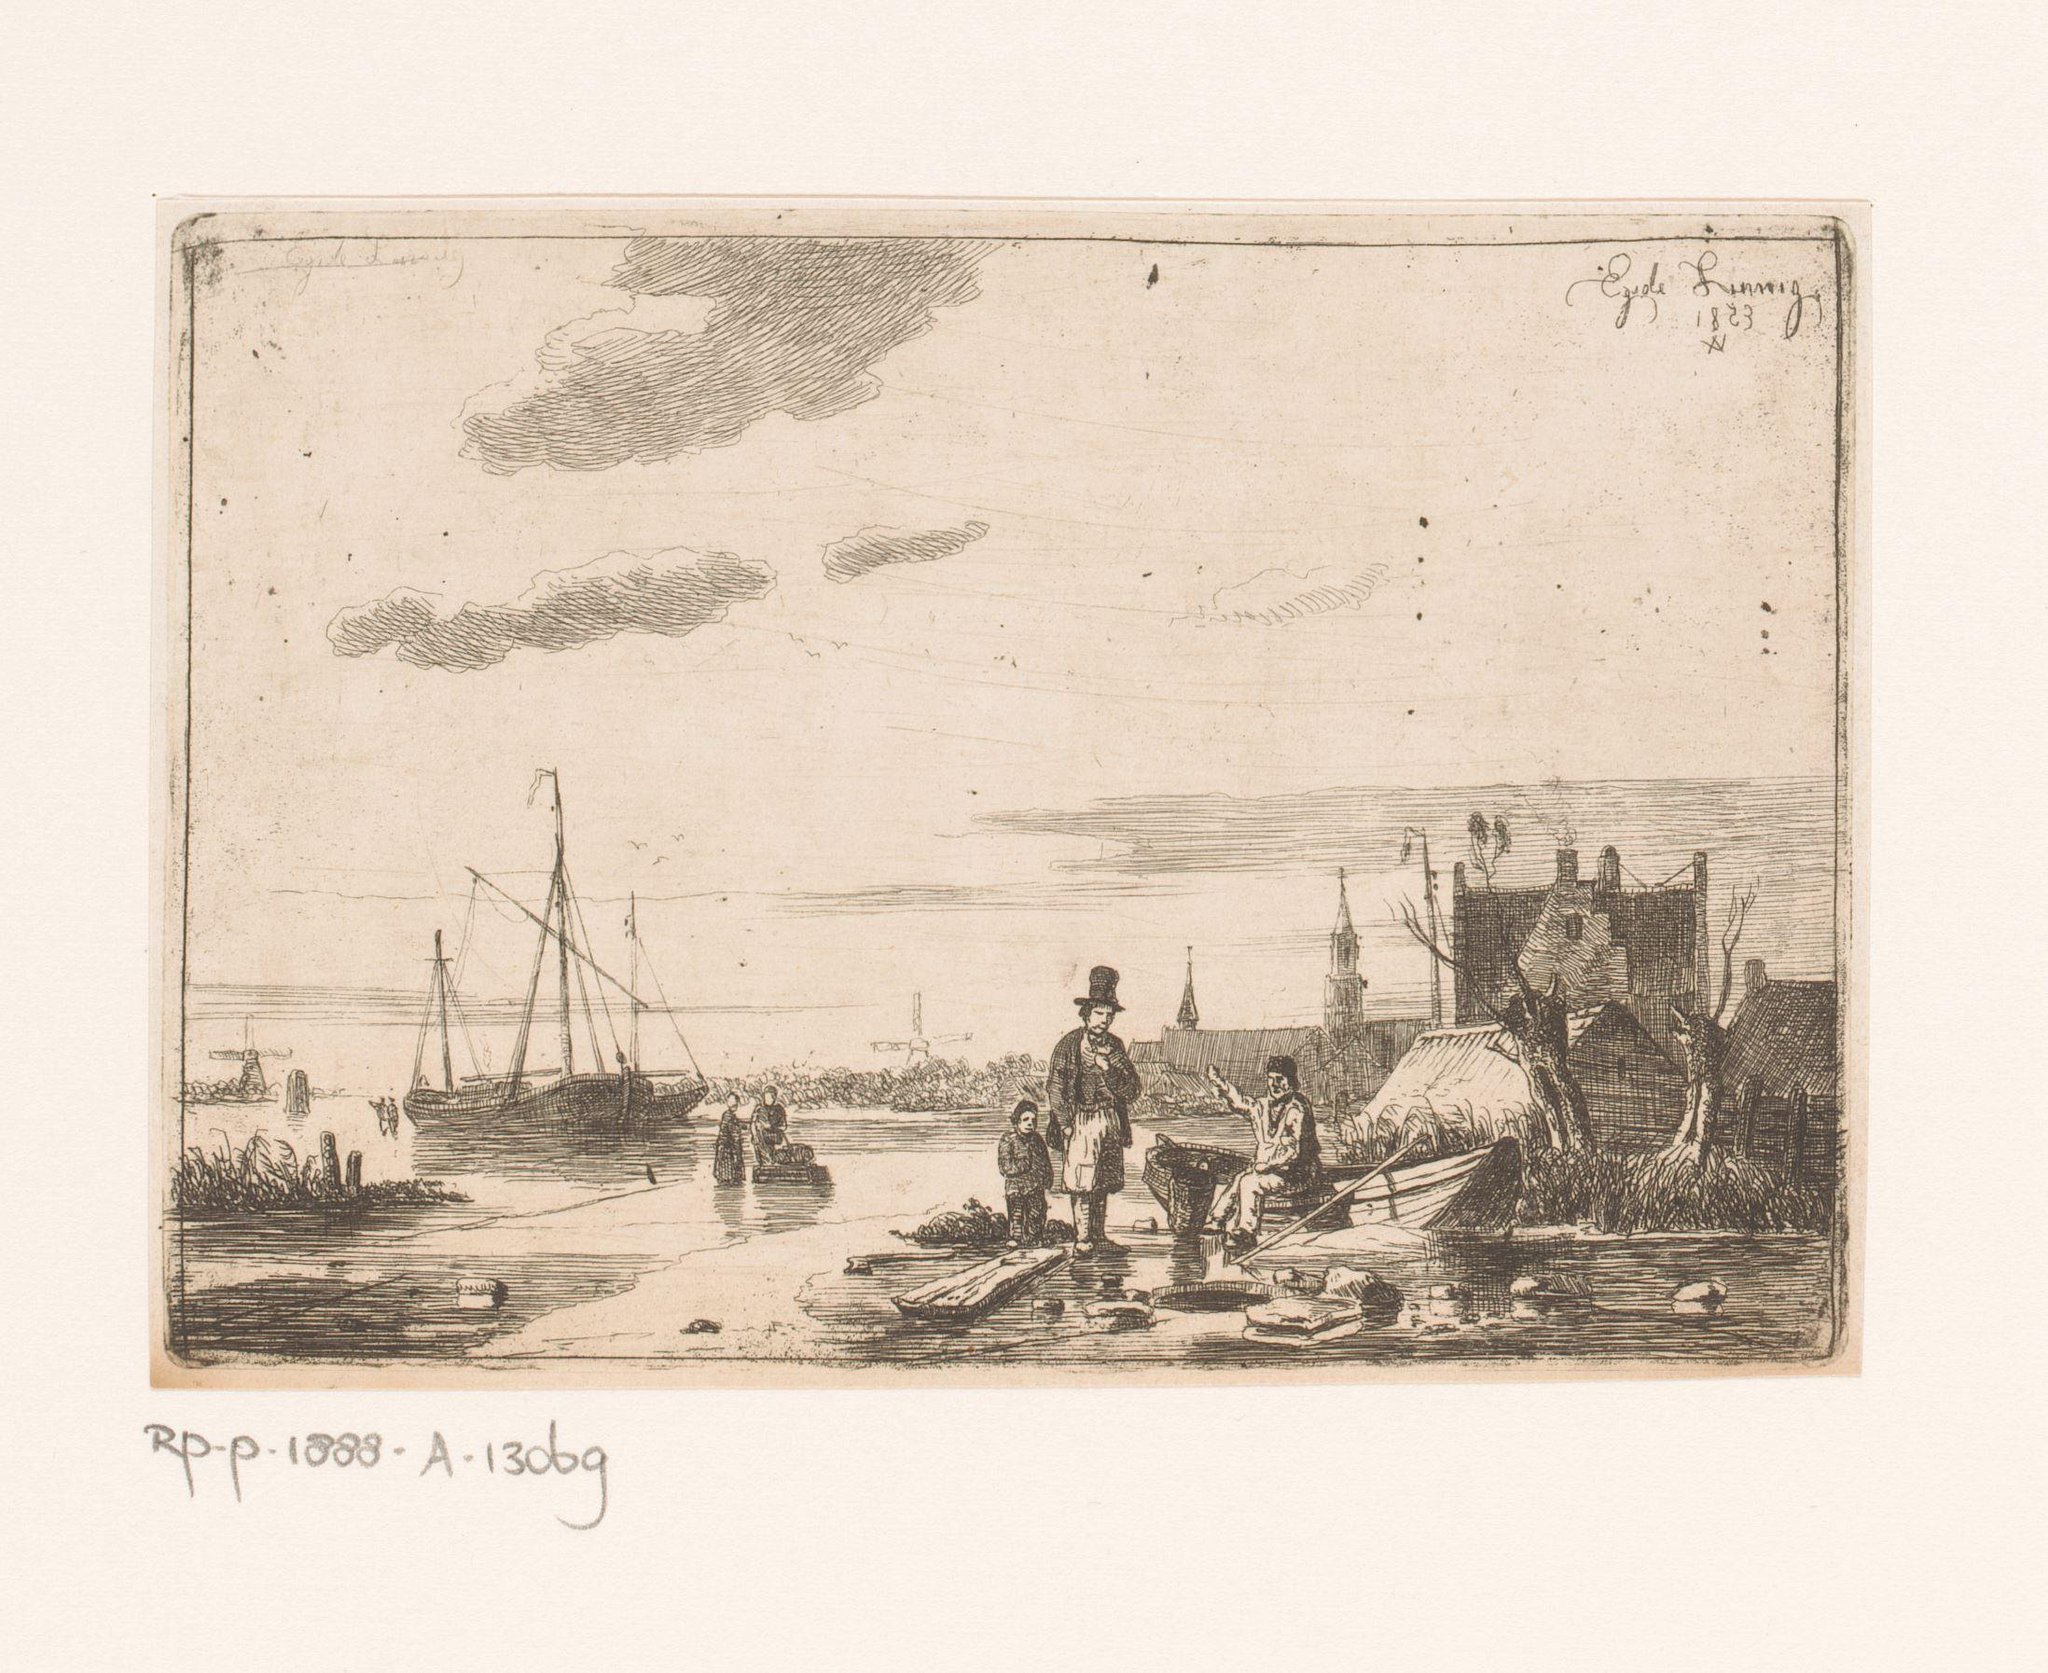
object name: print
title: Twee mannen en een kind rond een wak in het ijs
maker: egidius linnig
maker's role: draughtsman, print maker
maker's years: 1821-1860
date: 1853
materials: paper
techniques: etching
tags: sailing-ship, sailing-boat, ice ~ state of water, windmill, prospect of city, town panorama, silhouette of city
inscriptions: collector's mark: Lugt 2228